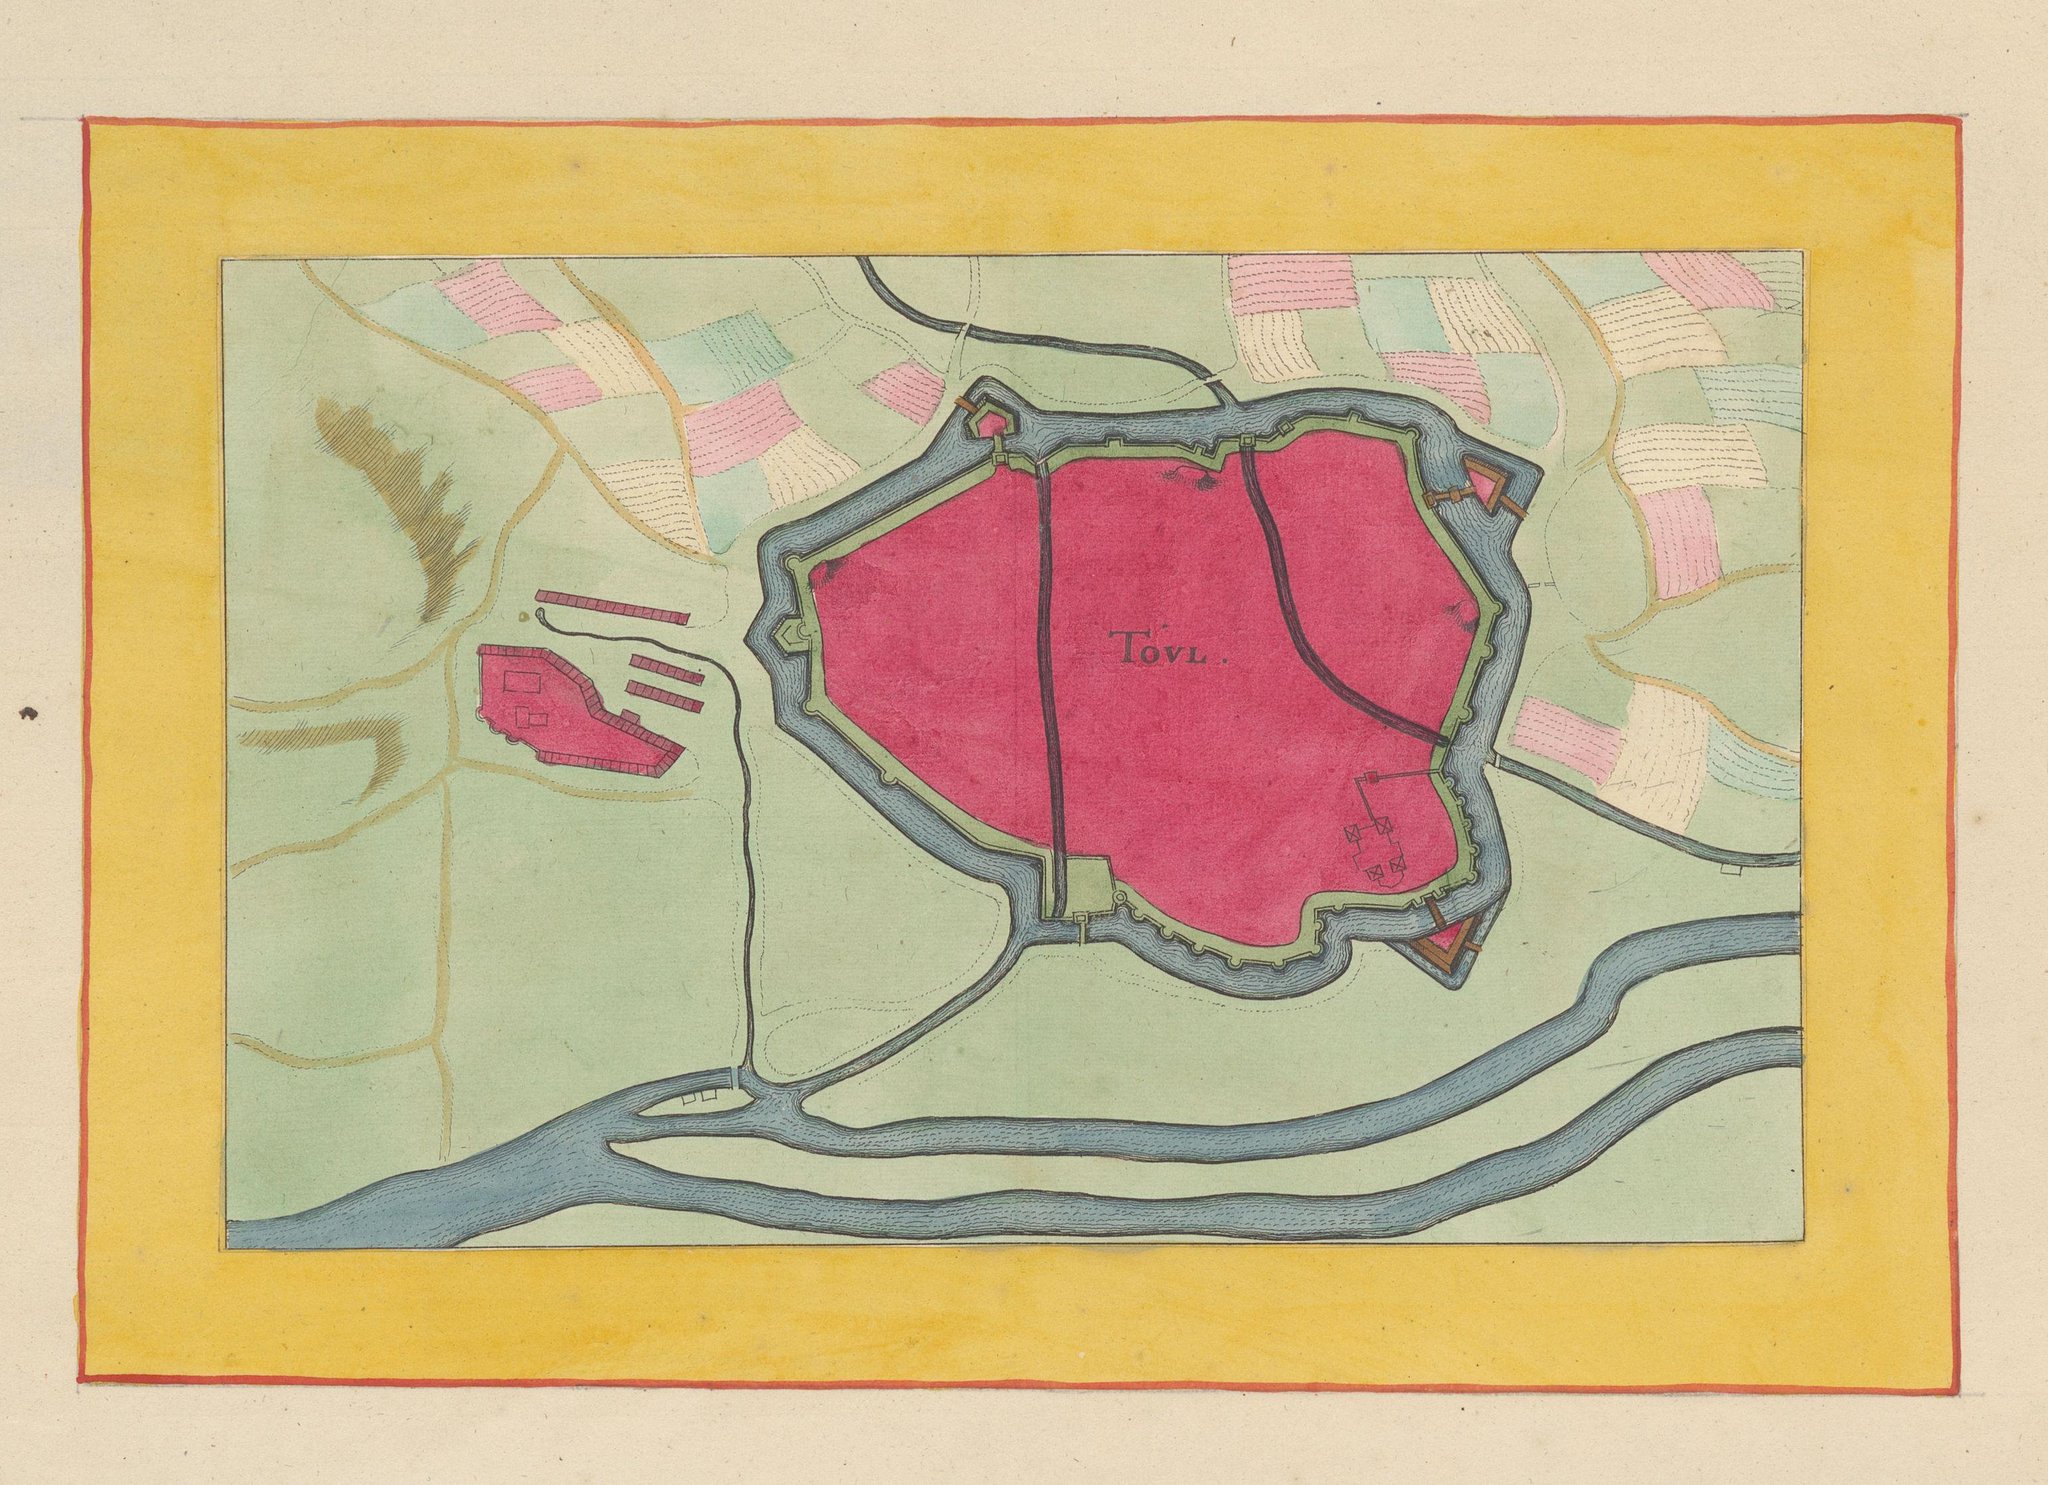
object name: album leaf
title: Vestingplattegrond van Toul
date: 1656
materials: paper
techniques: engraving, etching, hand coloring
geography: the hague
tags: maps of cities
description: Prent uit: Zeiller, Martin. Topographia Galliae. 13 dln. Frankfurt: Caspar Merian, 1656, dl. 3, na p. 34.